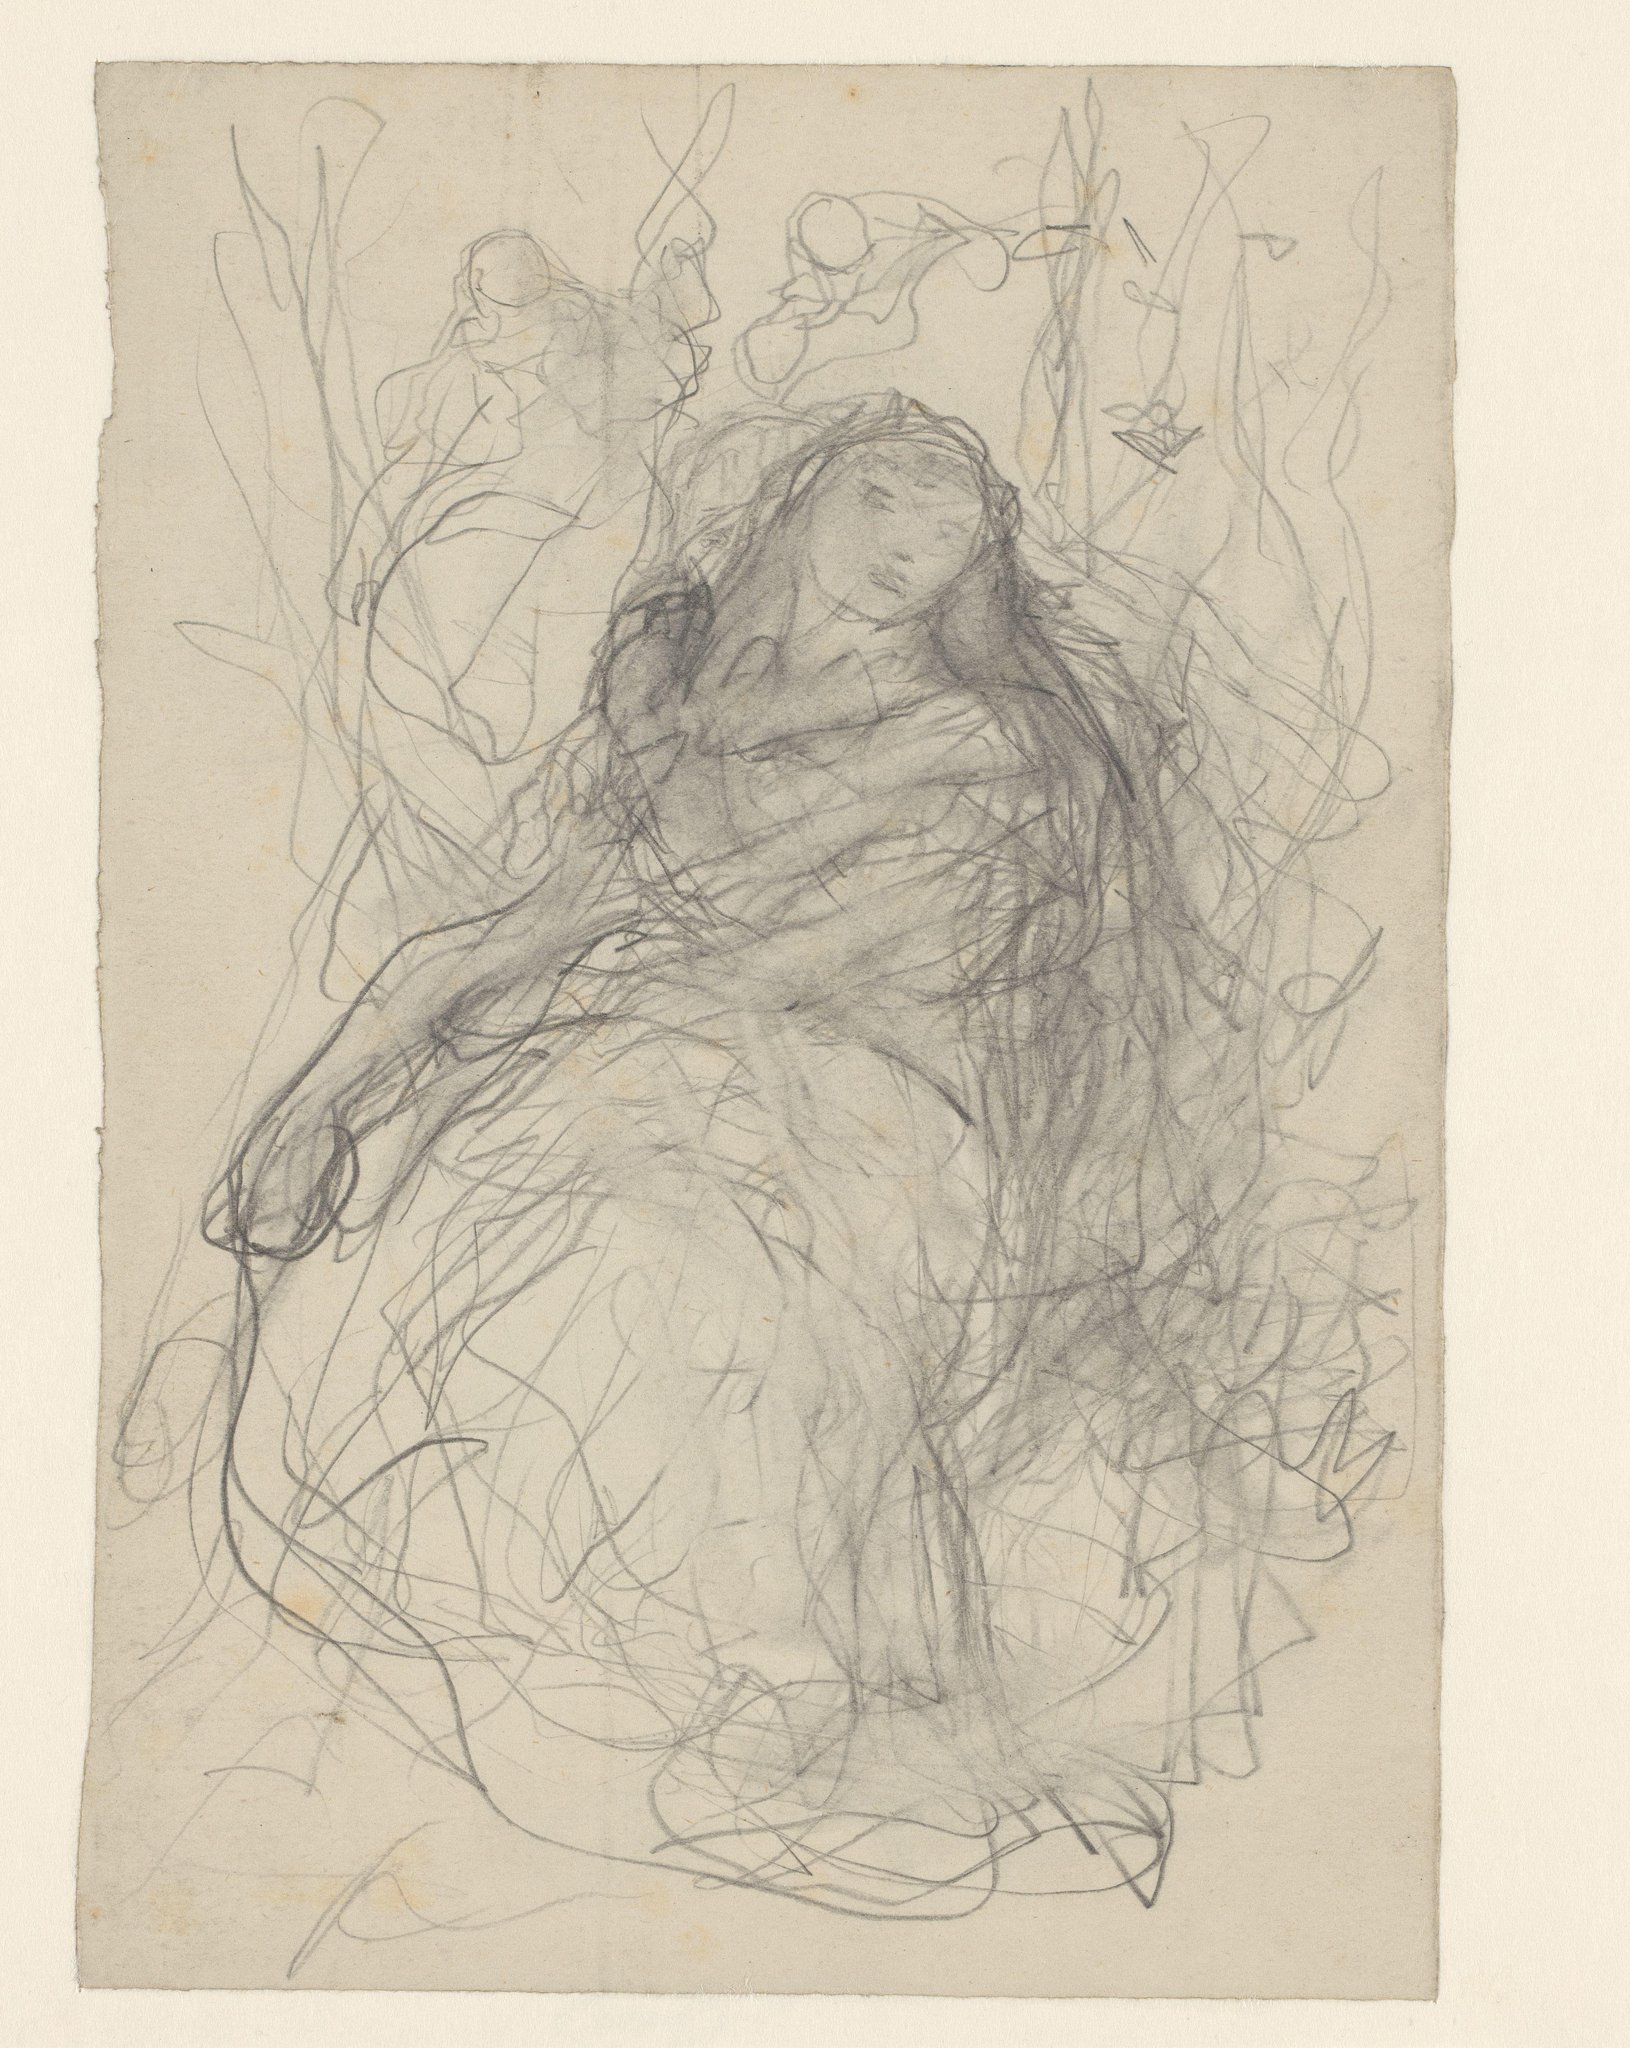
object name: drawing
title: Schets van een vrouw met vlinders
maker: matthijs maris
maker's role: draughtsman, painter, print maker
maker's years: 1839-1917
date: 1849-1917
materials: paper, pencil